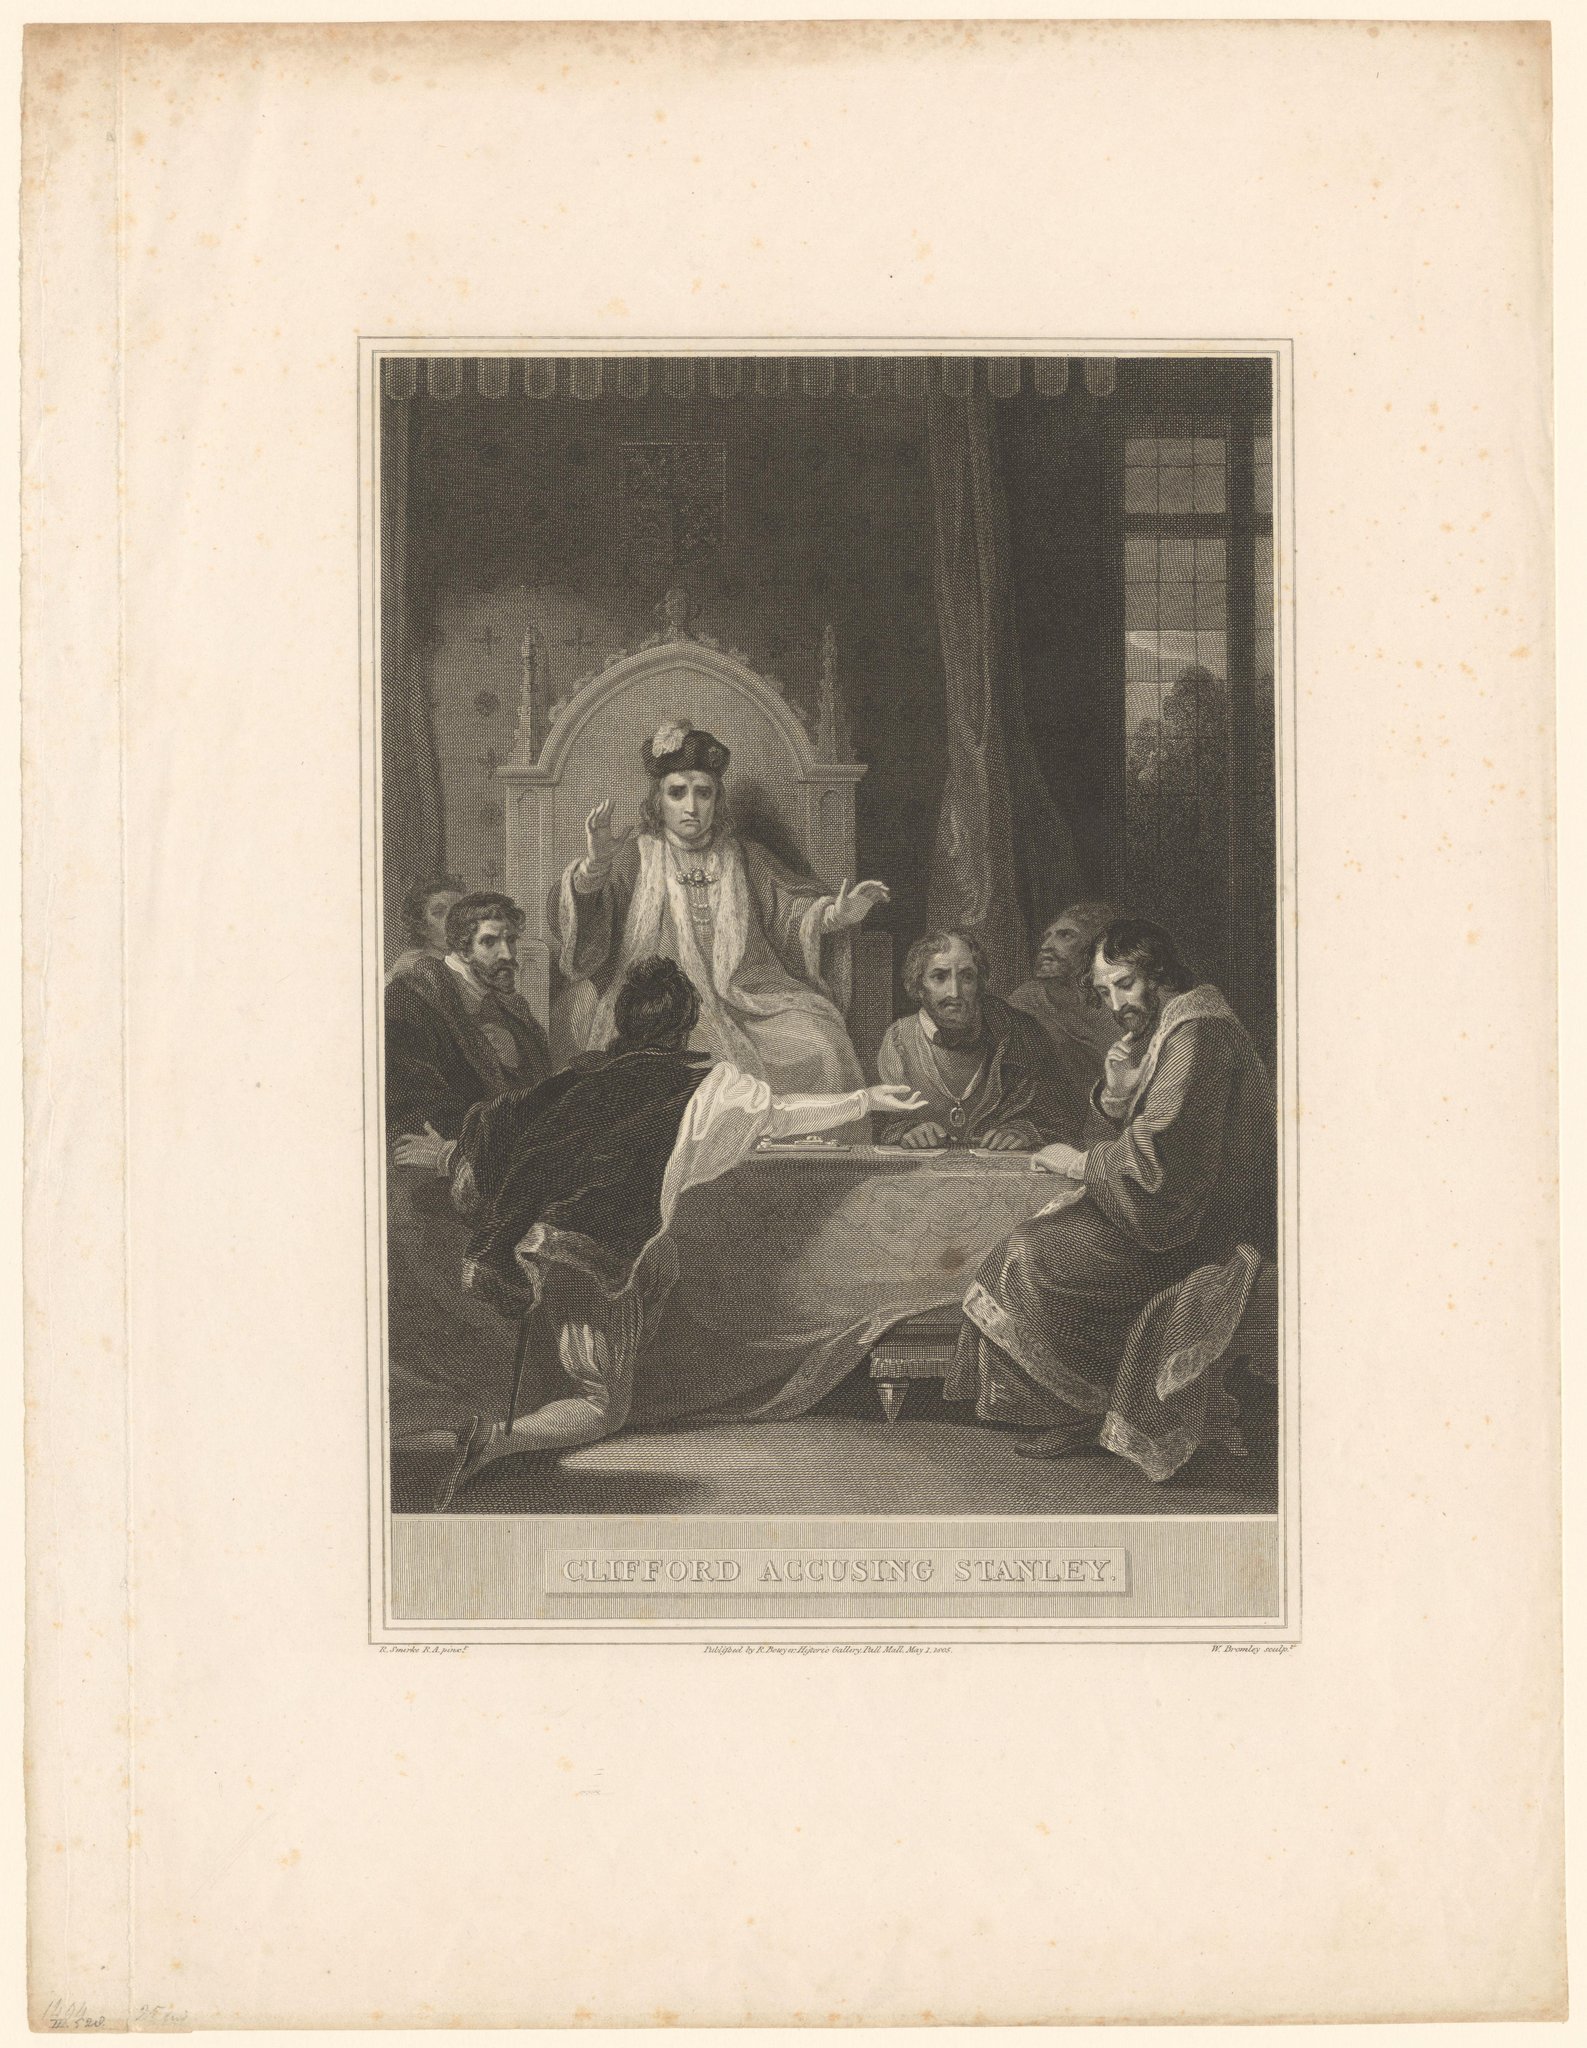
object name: print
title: Clifford accusing Stanley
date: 1805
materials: paper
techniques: engraving, etching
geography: london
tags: treason, king, accusing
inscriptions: collector's mark: Lugt 2228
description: Prent uit: Hume, David. The History of England. Londen: Robert Bowyer, 1805.